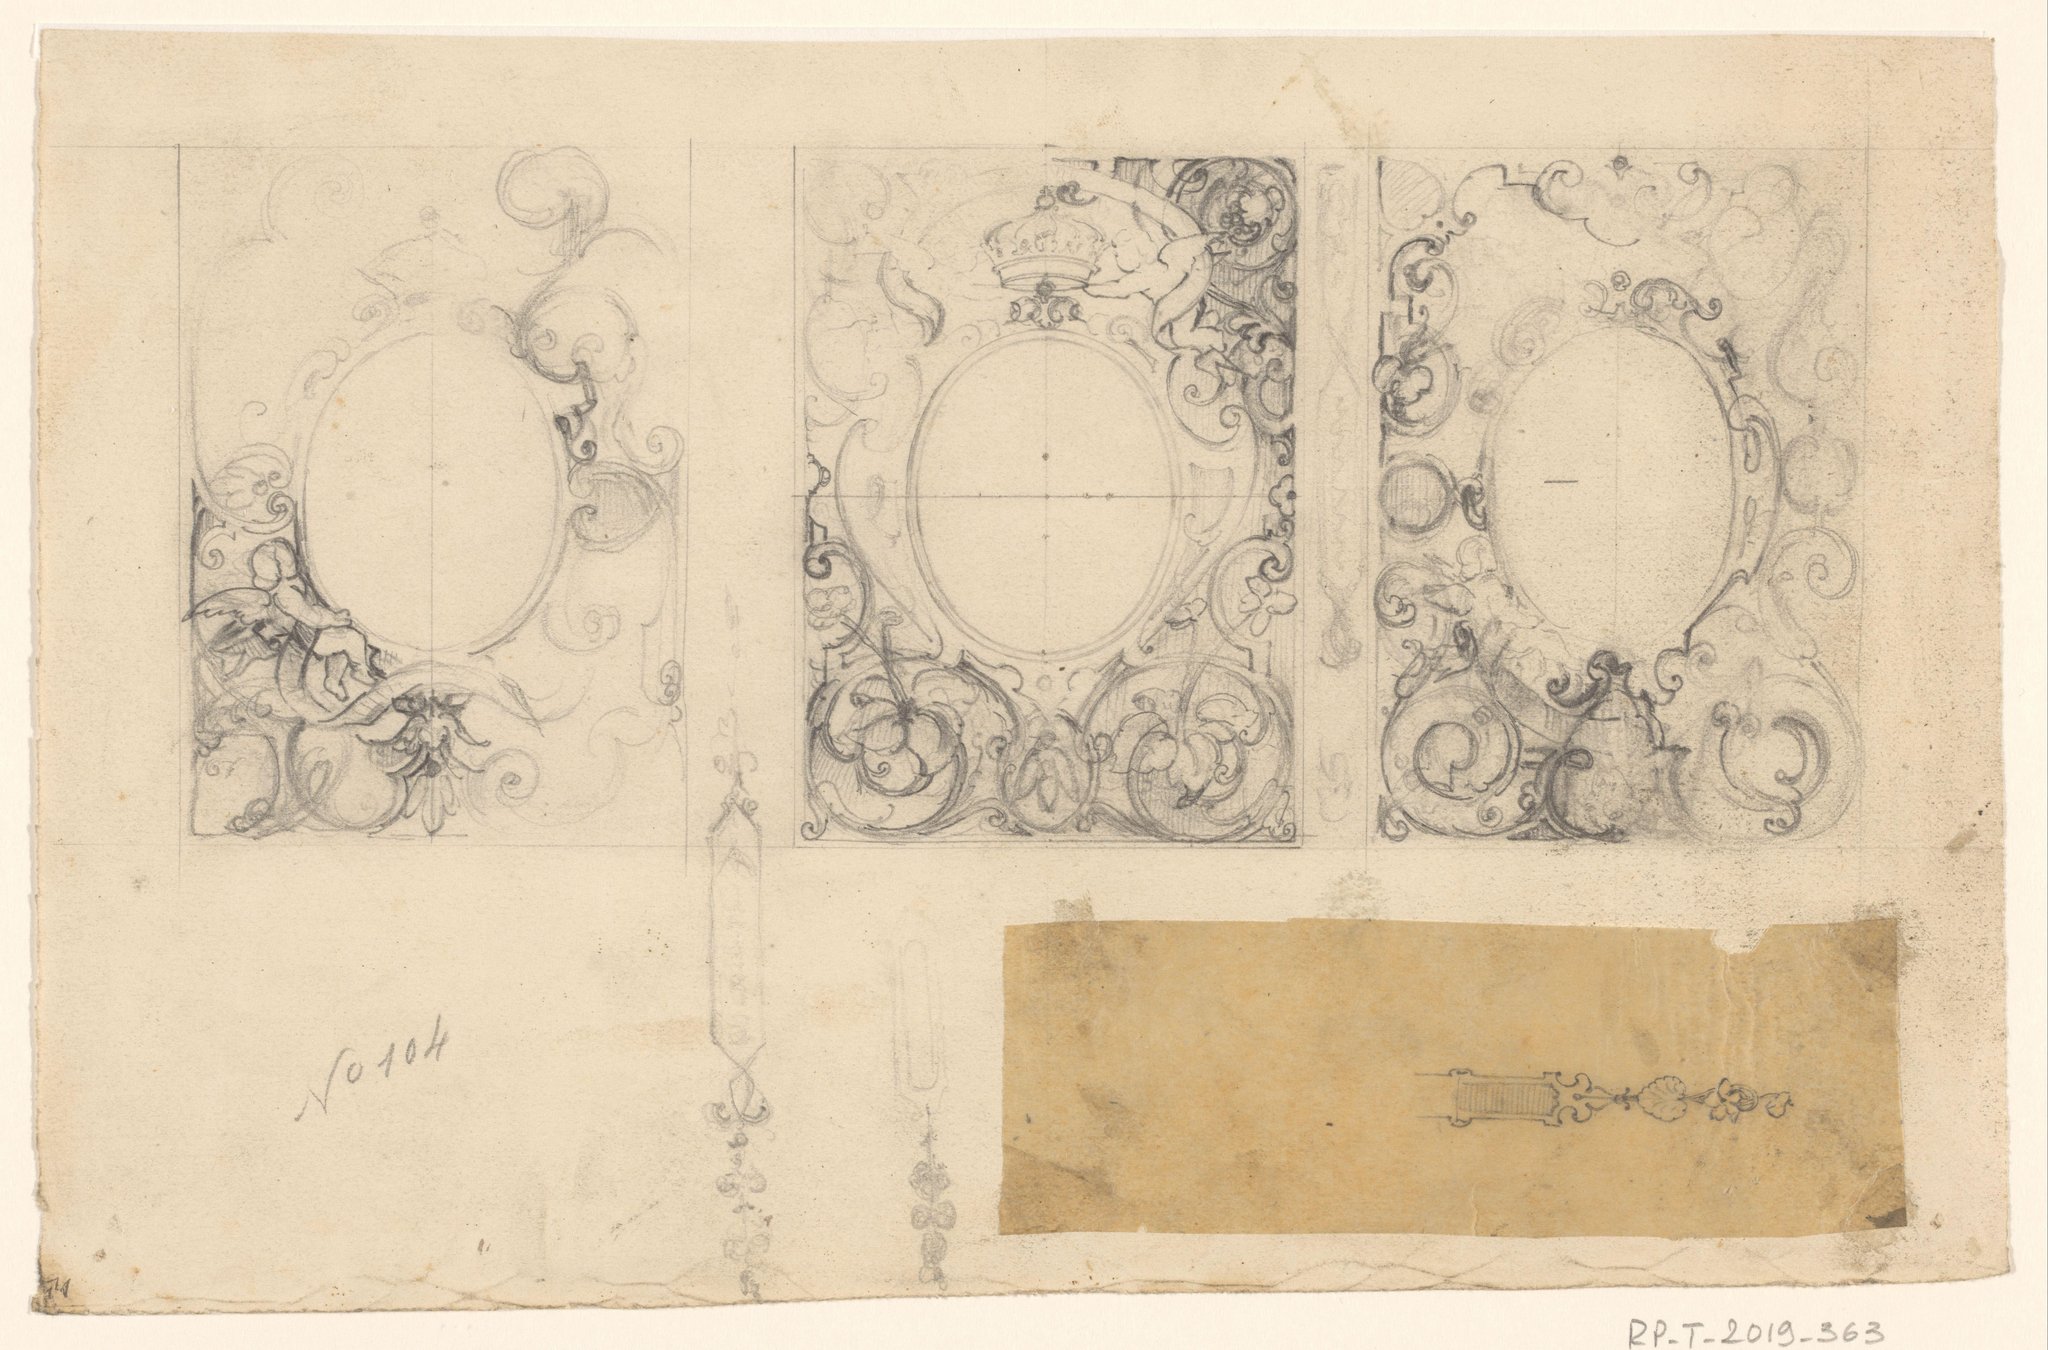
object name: design drawing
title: Drie ontwerpen voor boekbanden en vier ontwerpen voor de versiering van de rug van een boek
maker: Anonymous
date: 1840-1850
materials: graphite, paper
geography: paris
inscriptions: watermark, signature: ‘Bertrand-Paraud / orfevre Brevêté pour les Chapelles Royales / Rue des Arcis no 18’, number: ‘No 101’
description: De rechter twee ontwerpen tonen de voor- en achterzijde van een boekband, verbonden door het ontwerp voor de rug. Onder de banden zijn twee varianten voor de versiering van een rug geschetst, en een derde variant is getekend op een opgeplakt stukje overtrekpapier.